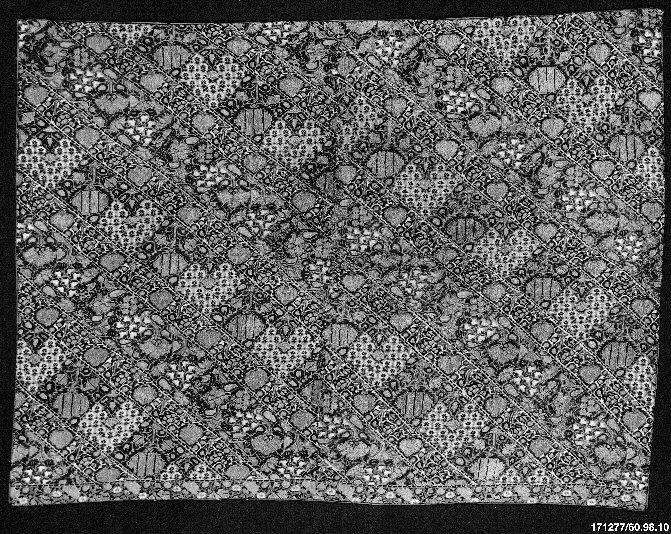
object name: trousering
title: Fragment of Woman's Trousering (Nakshe)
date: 1701-1800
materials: metal thread, silk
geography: iran